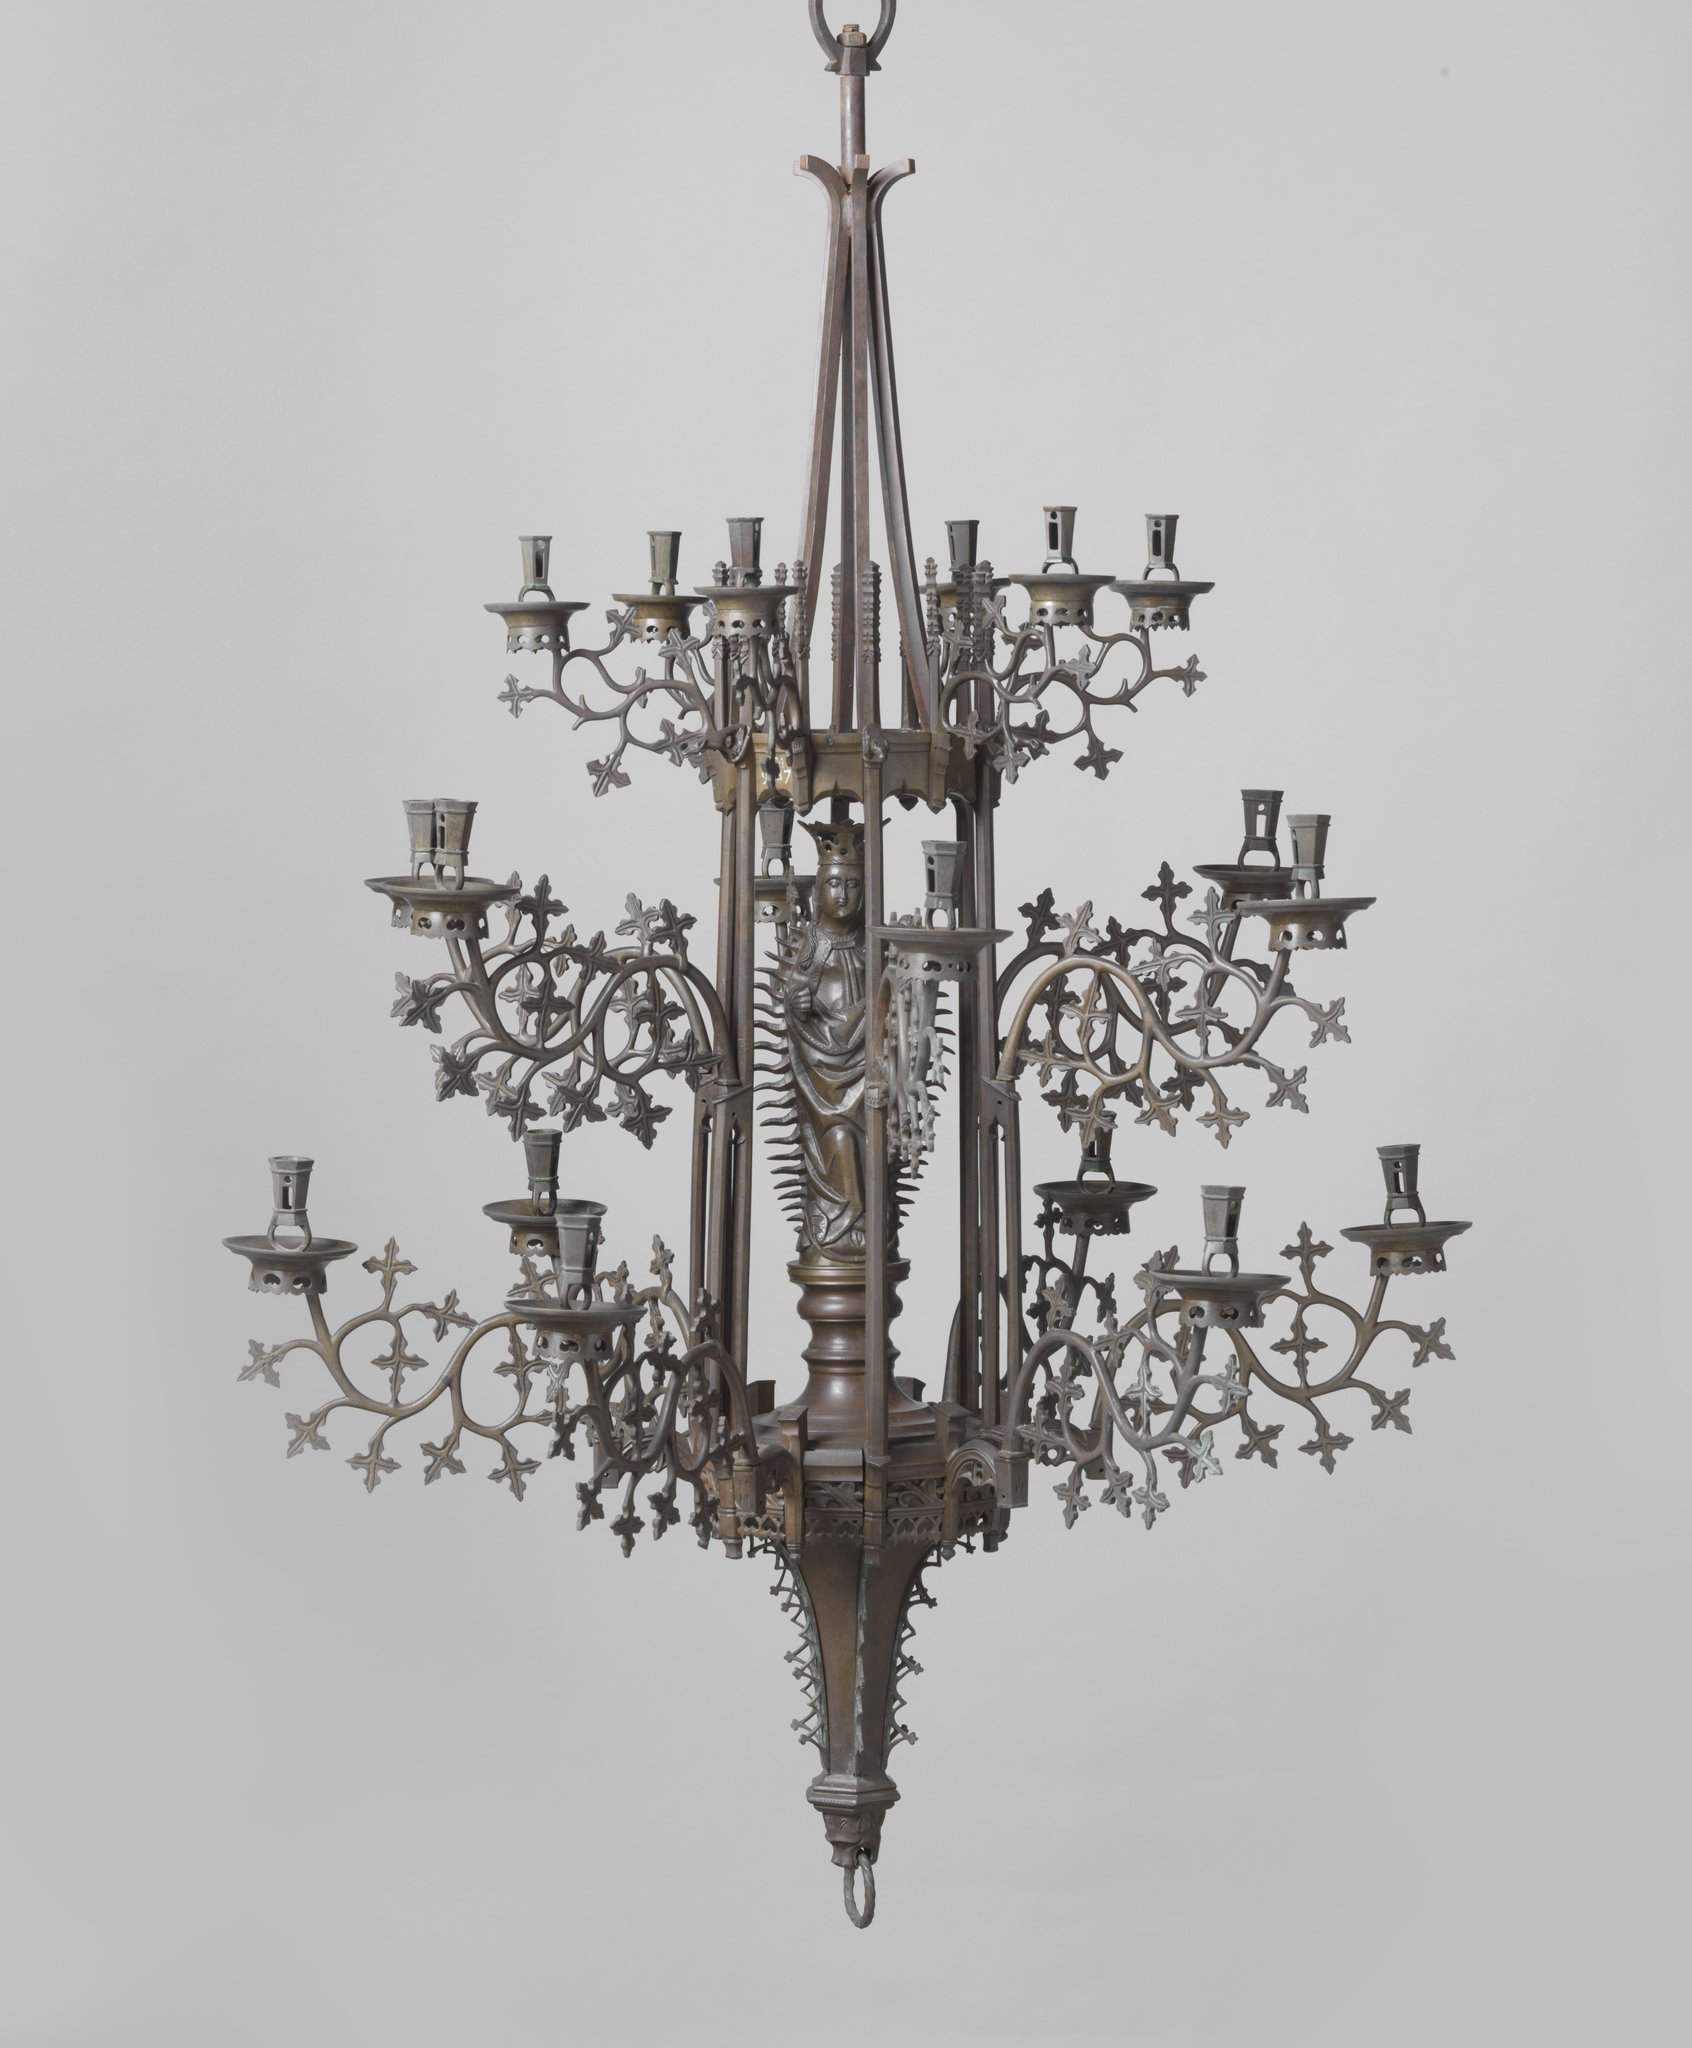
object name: kaarsenarm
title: Kaarsenarm van kaarsenkroon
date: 1475-1485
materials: brass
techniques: casting, metalworking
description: Kaarsenarm behorende bij een kaarsenkroon van drie hoogten met Mariakapel in het midden. De arm is twee maal gebogen en heeft elf bladeren. Aan het uiteinde rust de vetvanger, die aan de onderzijde een verticale gekartelde rand met kruisbloemmotieven heeft. De kaarsenhouder is zesvlakkig met een geperforeerde zijde aan voor- en achterkant en heeft een verticaal ringvormig onderstuk. Dit is de vijfde arm van de onderste ring (voetstuk), genummerd met 5 stippen.